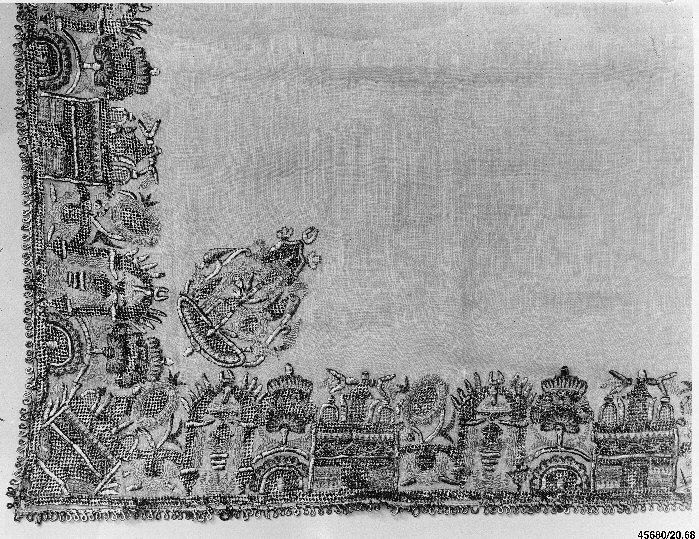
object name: veil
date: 1801-1833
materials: cotton, silk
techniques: embroidery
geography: turkey